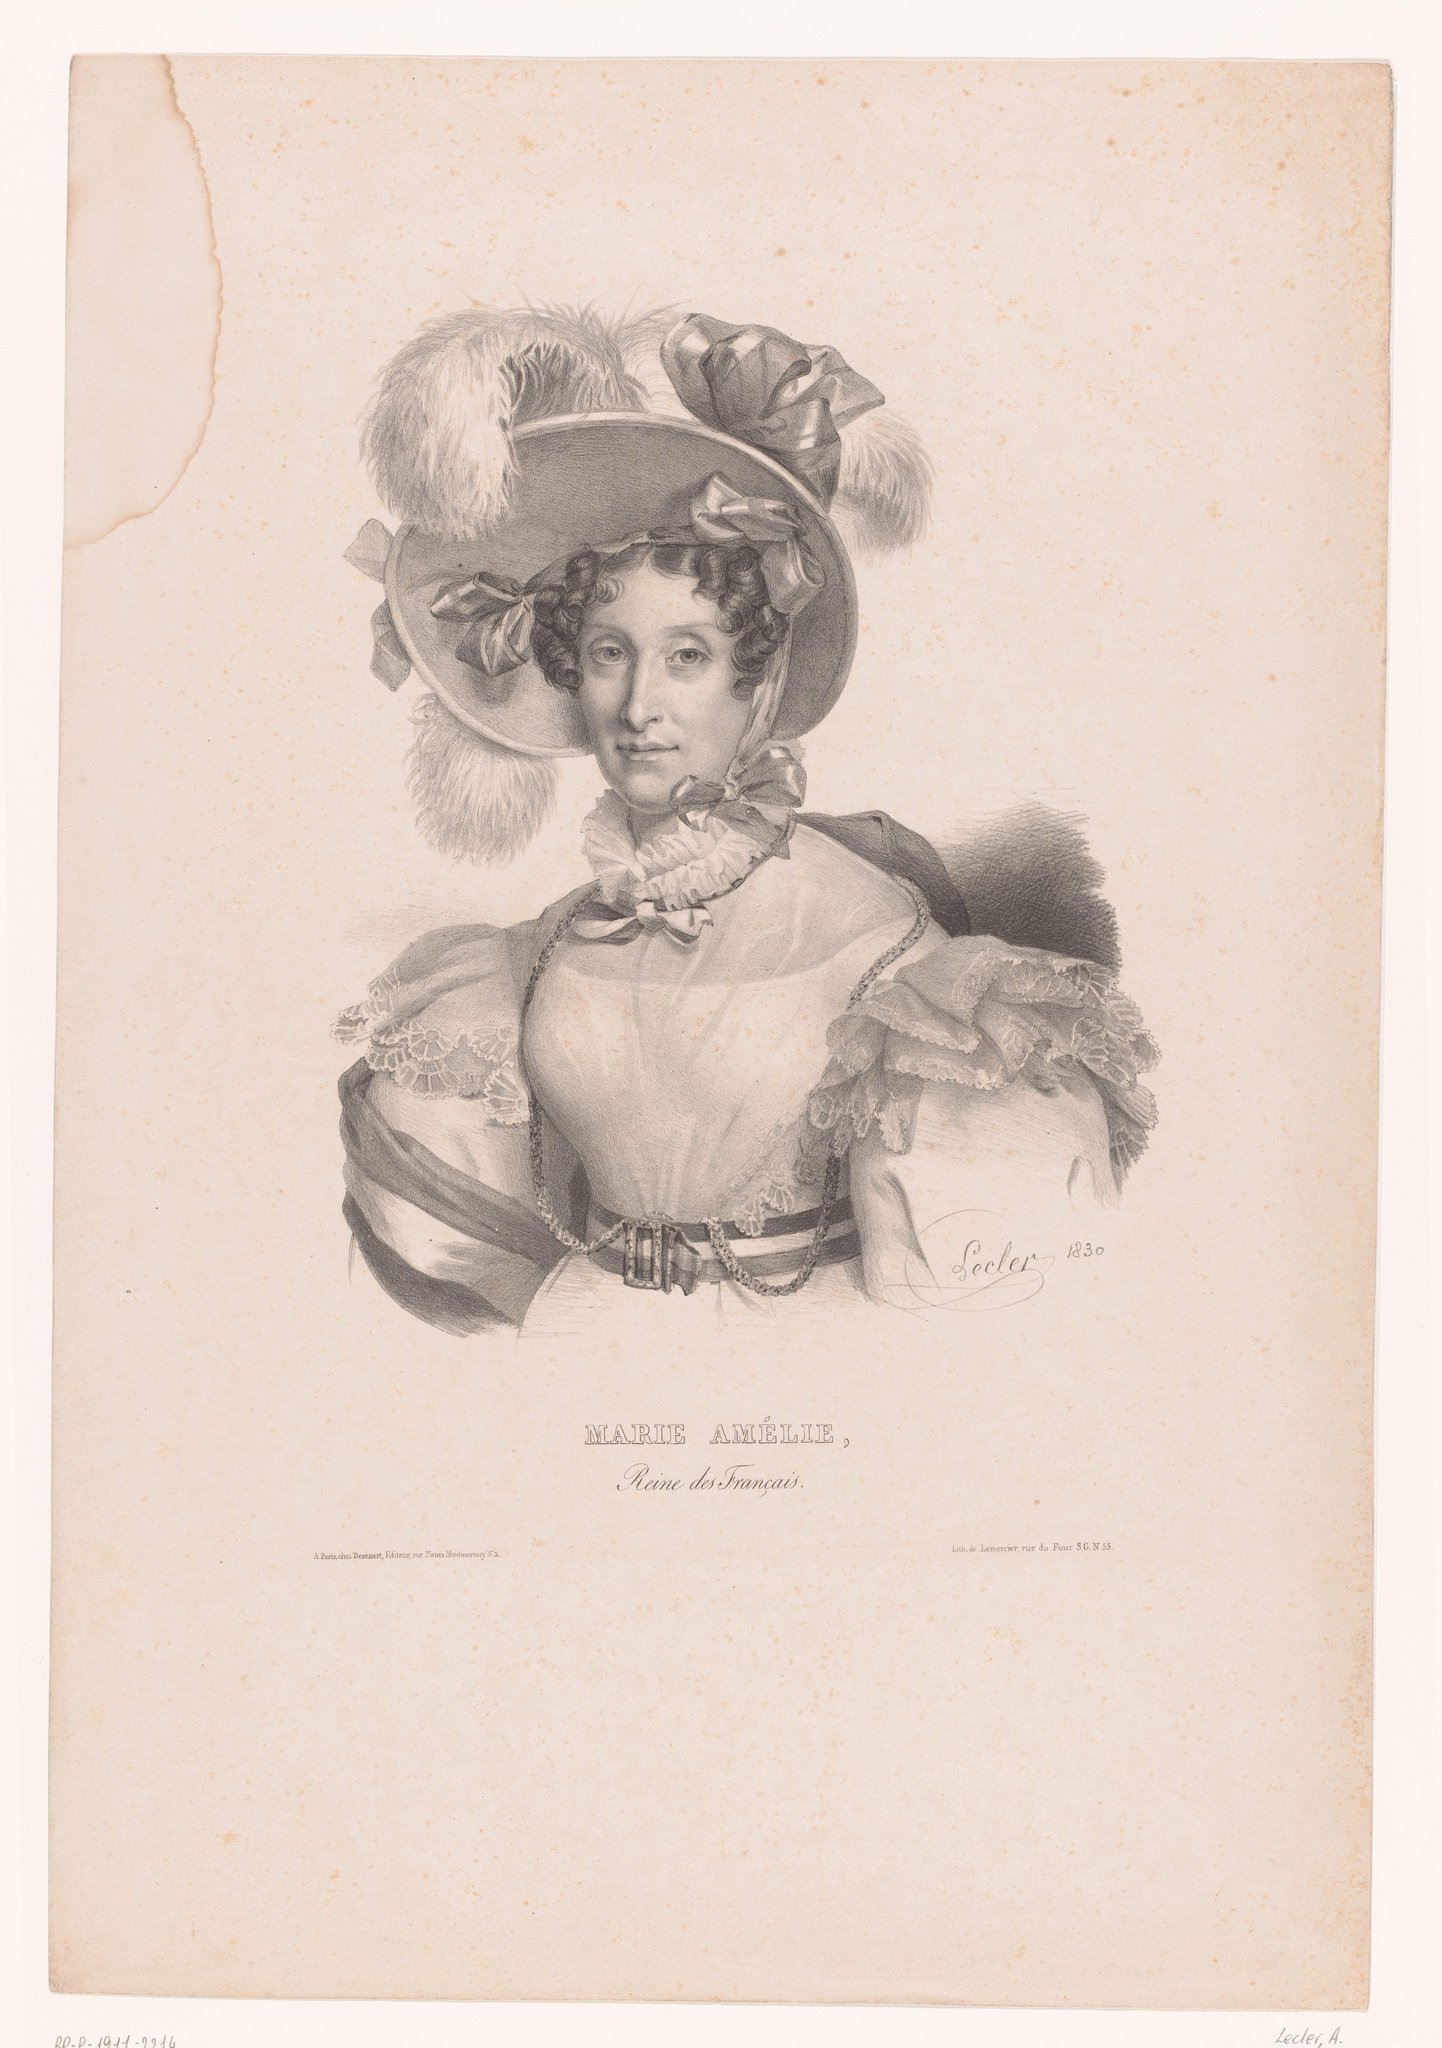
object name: print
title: Portret van Marie Amélie van Bourbon-Sicilië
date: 1830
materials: paper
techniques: lithograph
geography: paris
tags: caserta, london, historical persons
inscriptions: collector's mark: Lugt 2228a